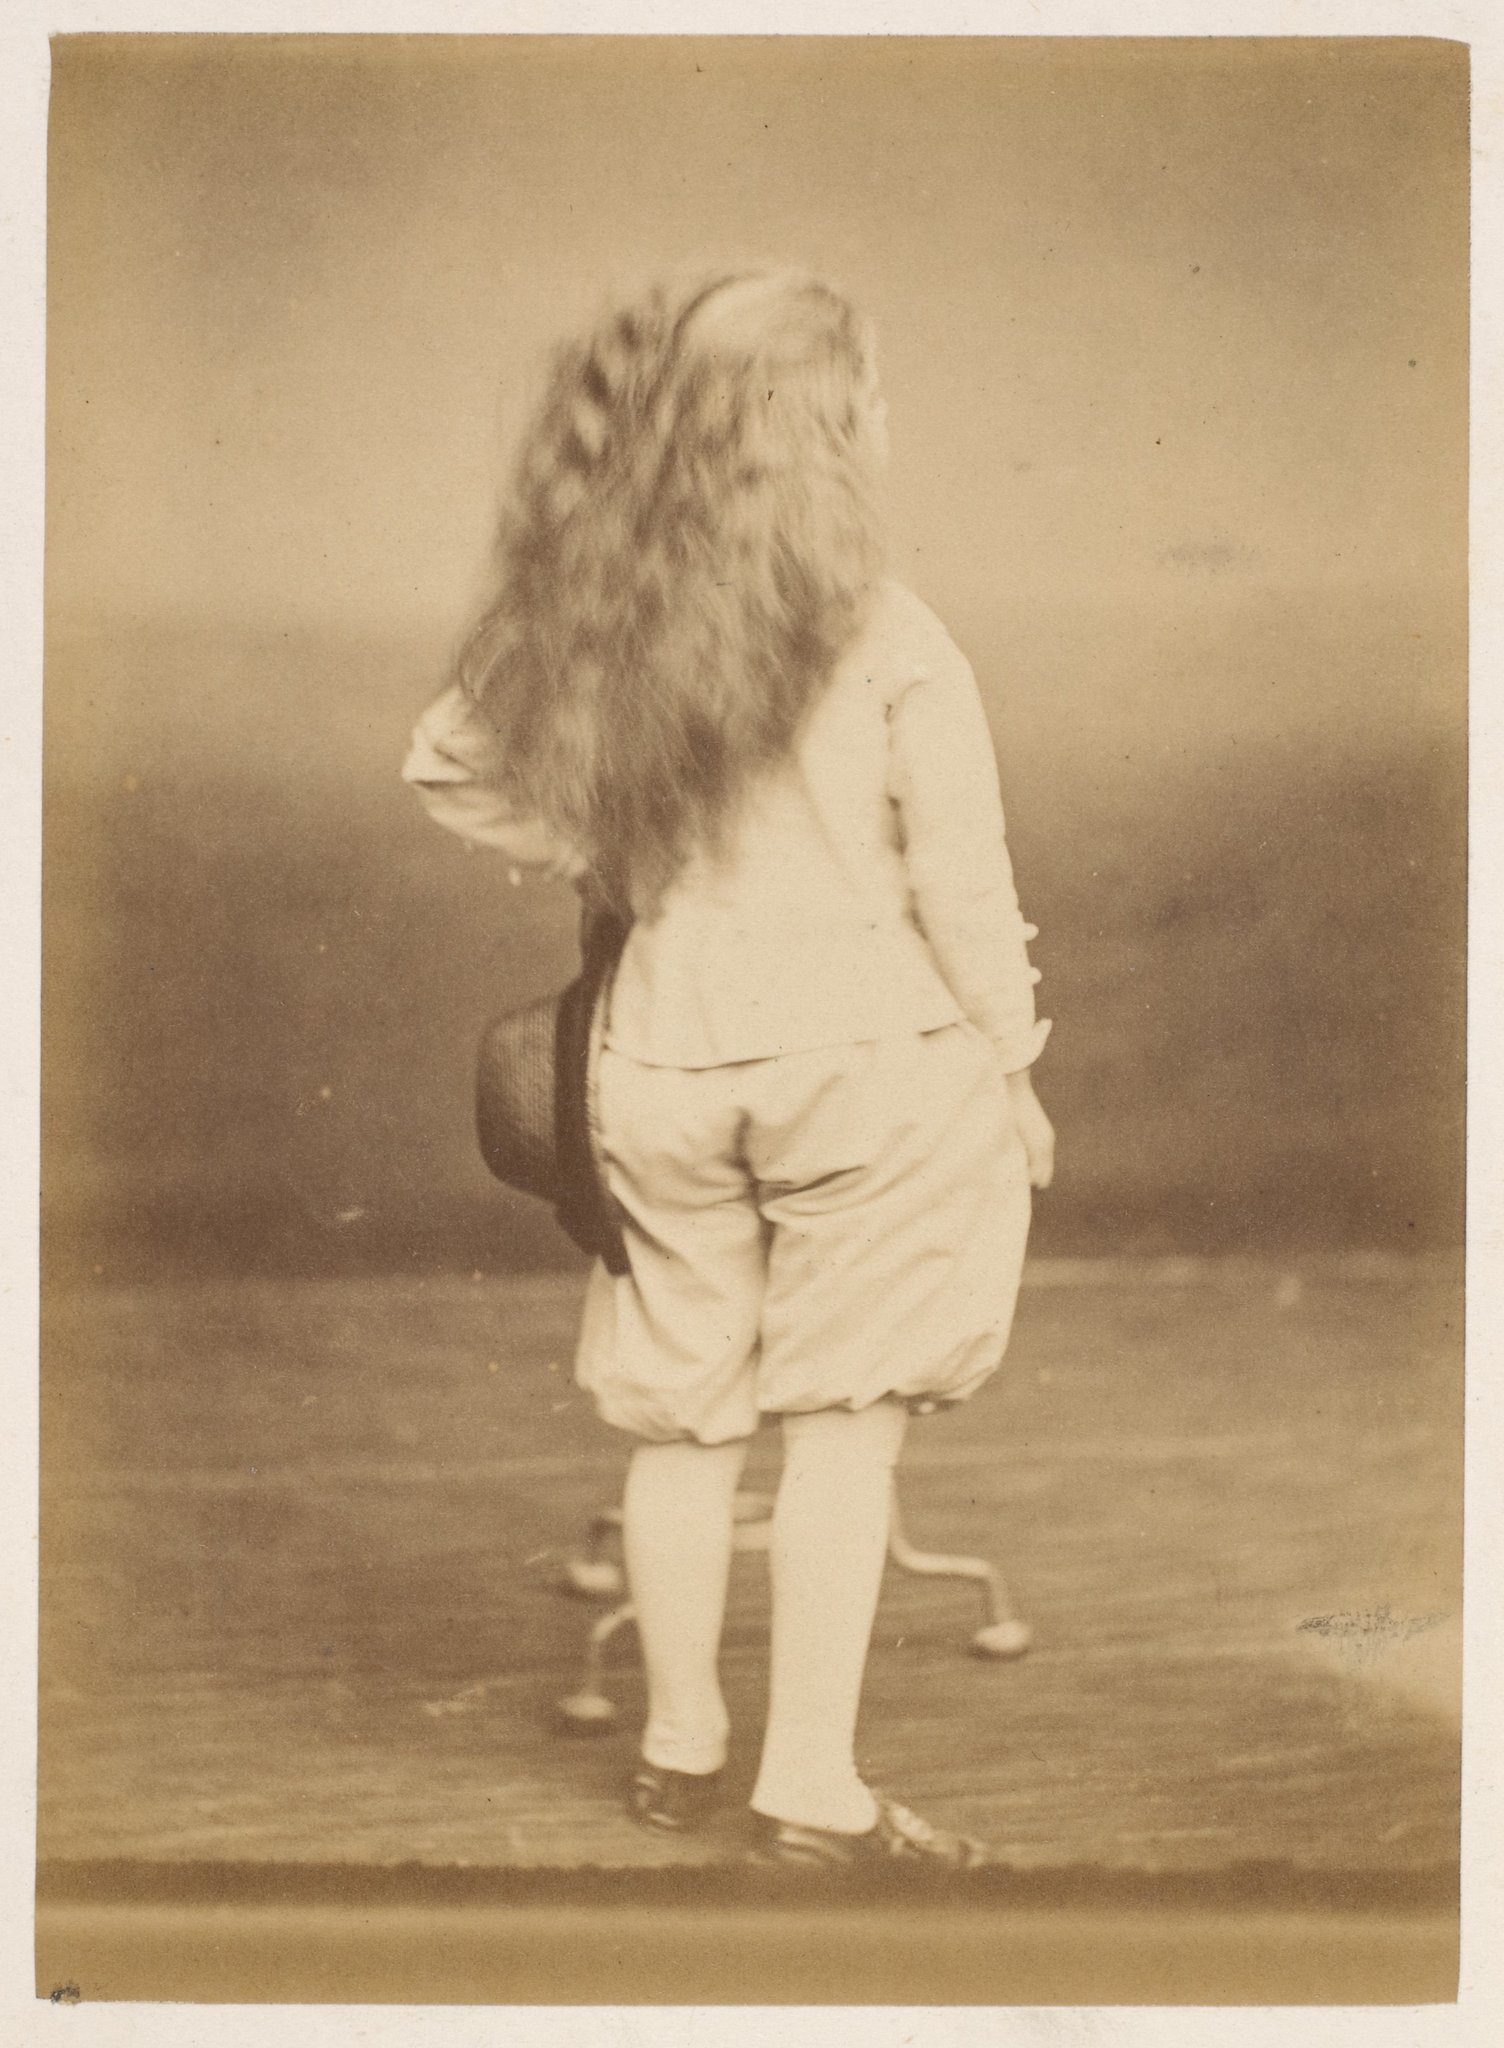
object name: photograph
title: L'Enfant blanc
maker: pierre-louis pierson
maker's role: artist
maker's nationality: french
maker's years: 1822-1913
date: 1860-1869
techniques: albumen silver print, glass negative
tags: girls